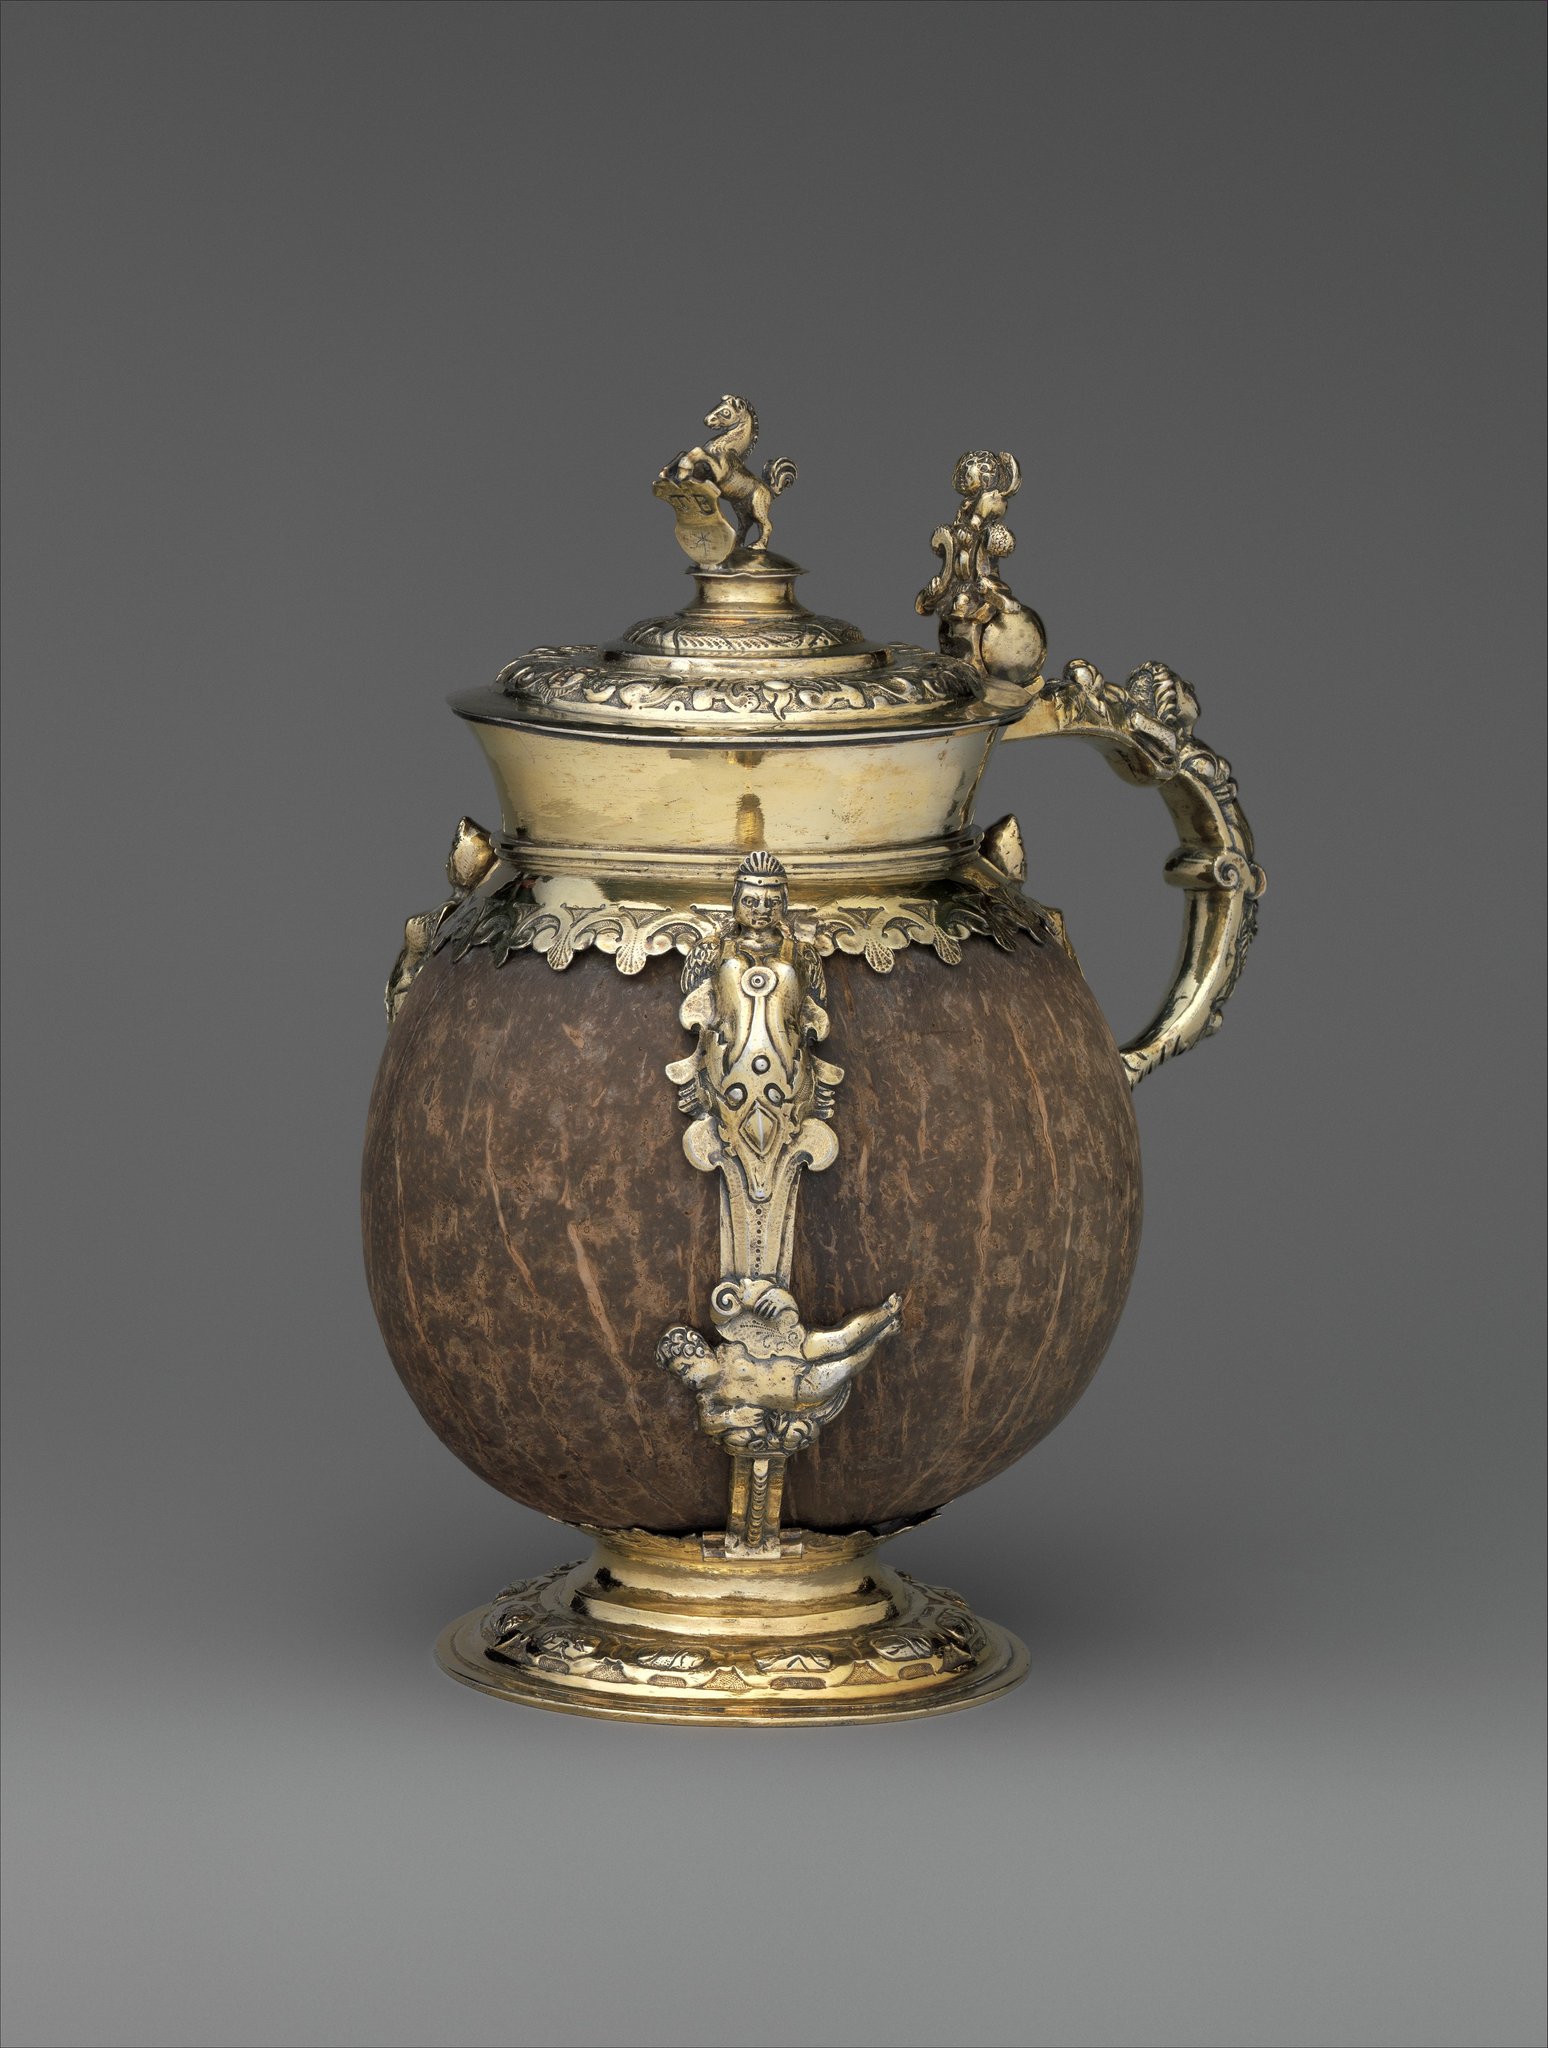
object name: tankard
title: Coconut tankard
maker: andreas fleischer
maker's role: maker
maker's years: 1605-1618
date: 1601-1633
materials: plant material, gilt silver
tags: horses